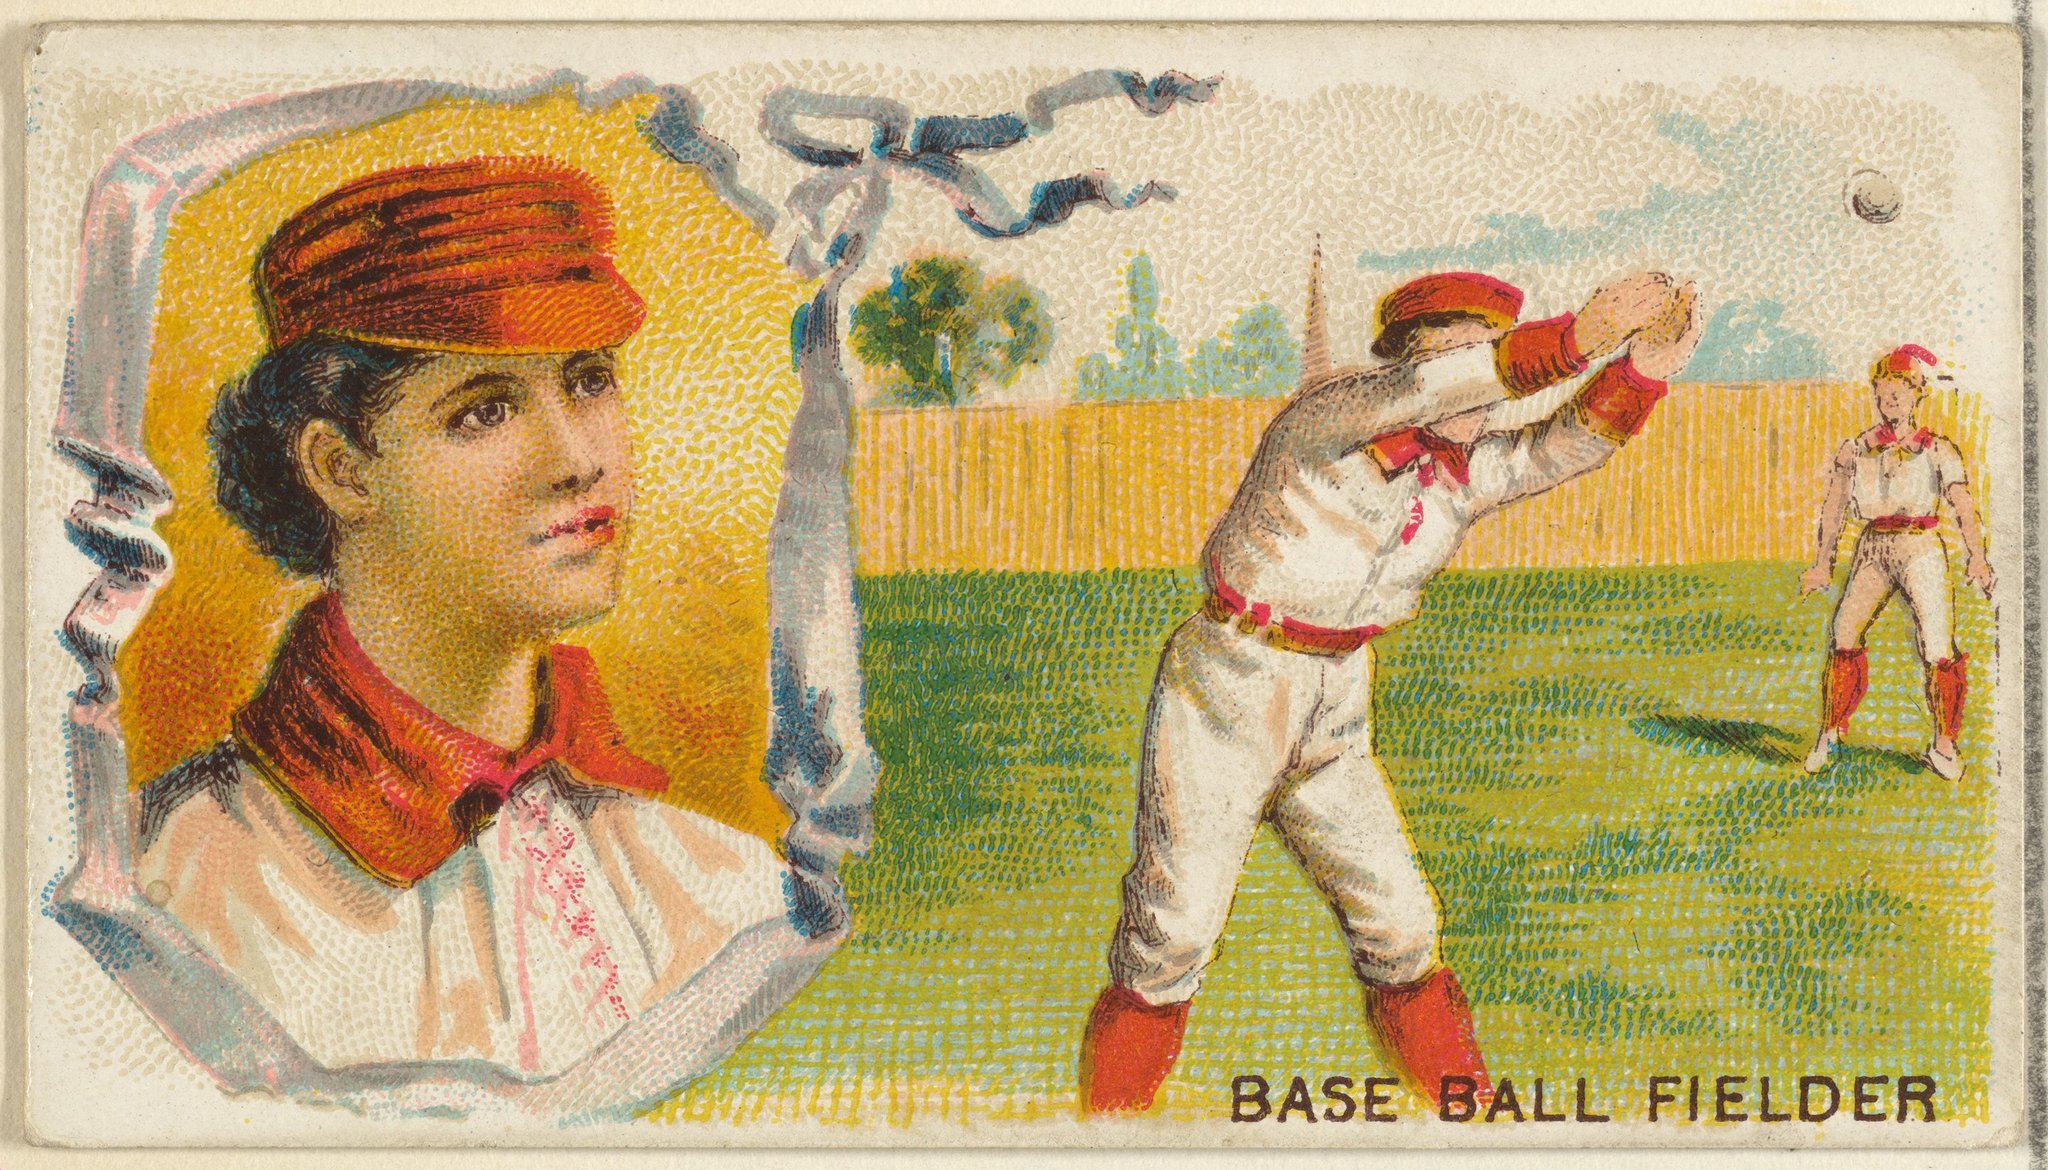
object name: baseball card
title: Baseball Fielder, from the Games and Sports series (N165) for Old Judge Cigarettes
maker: goodwin & company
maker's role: publisher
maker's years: 1850-1950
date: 1889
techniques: color lithograph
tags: men,baseball,athletes